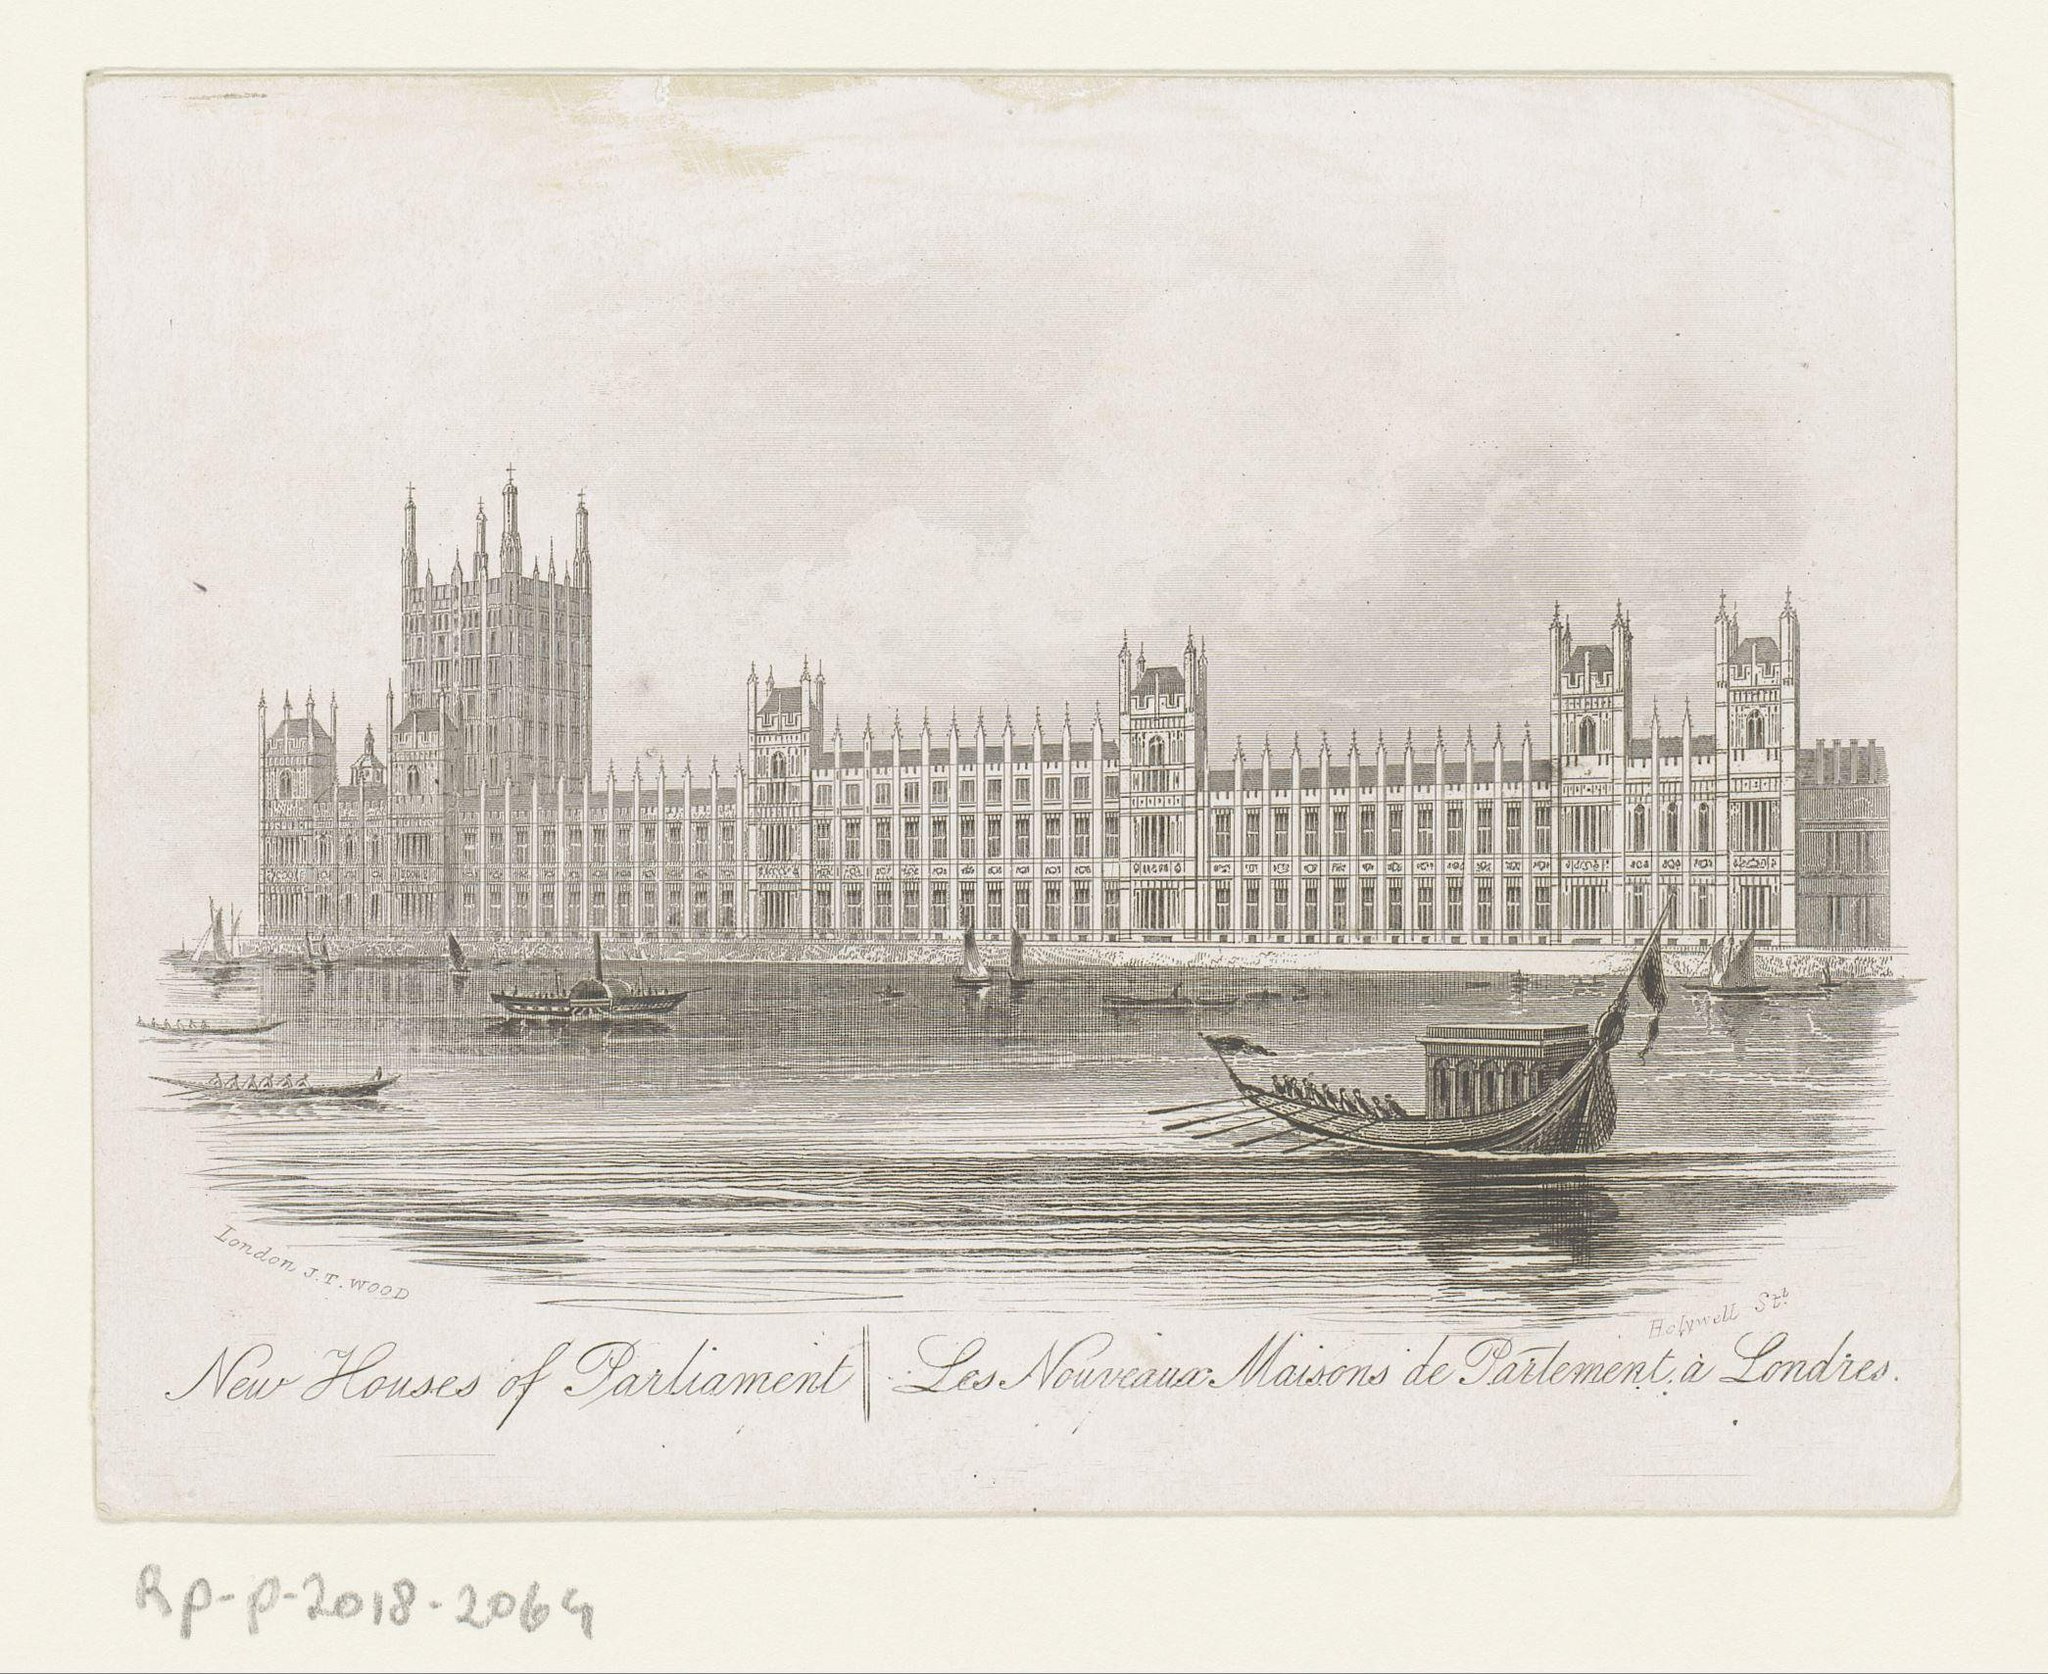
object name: print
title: Gezicht op de Houses of Parliament, te Londen, gezien vanaf de Theems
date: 1870-1885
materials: paper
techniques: etching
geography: london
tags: lower house, parliament, chamber